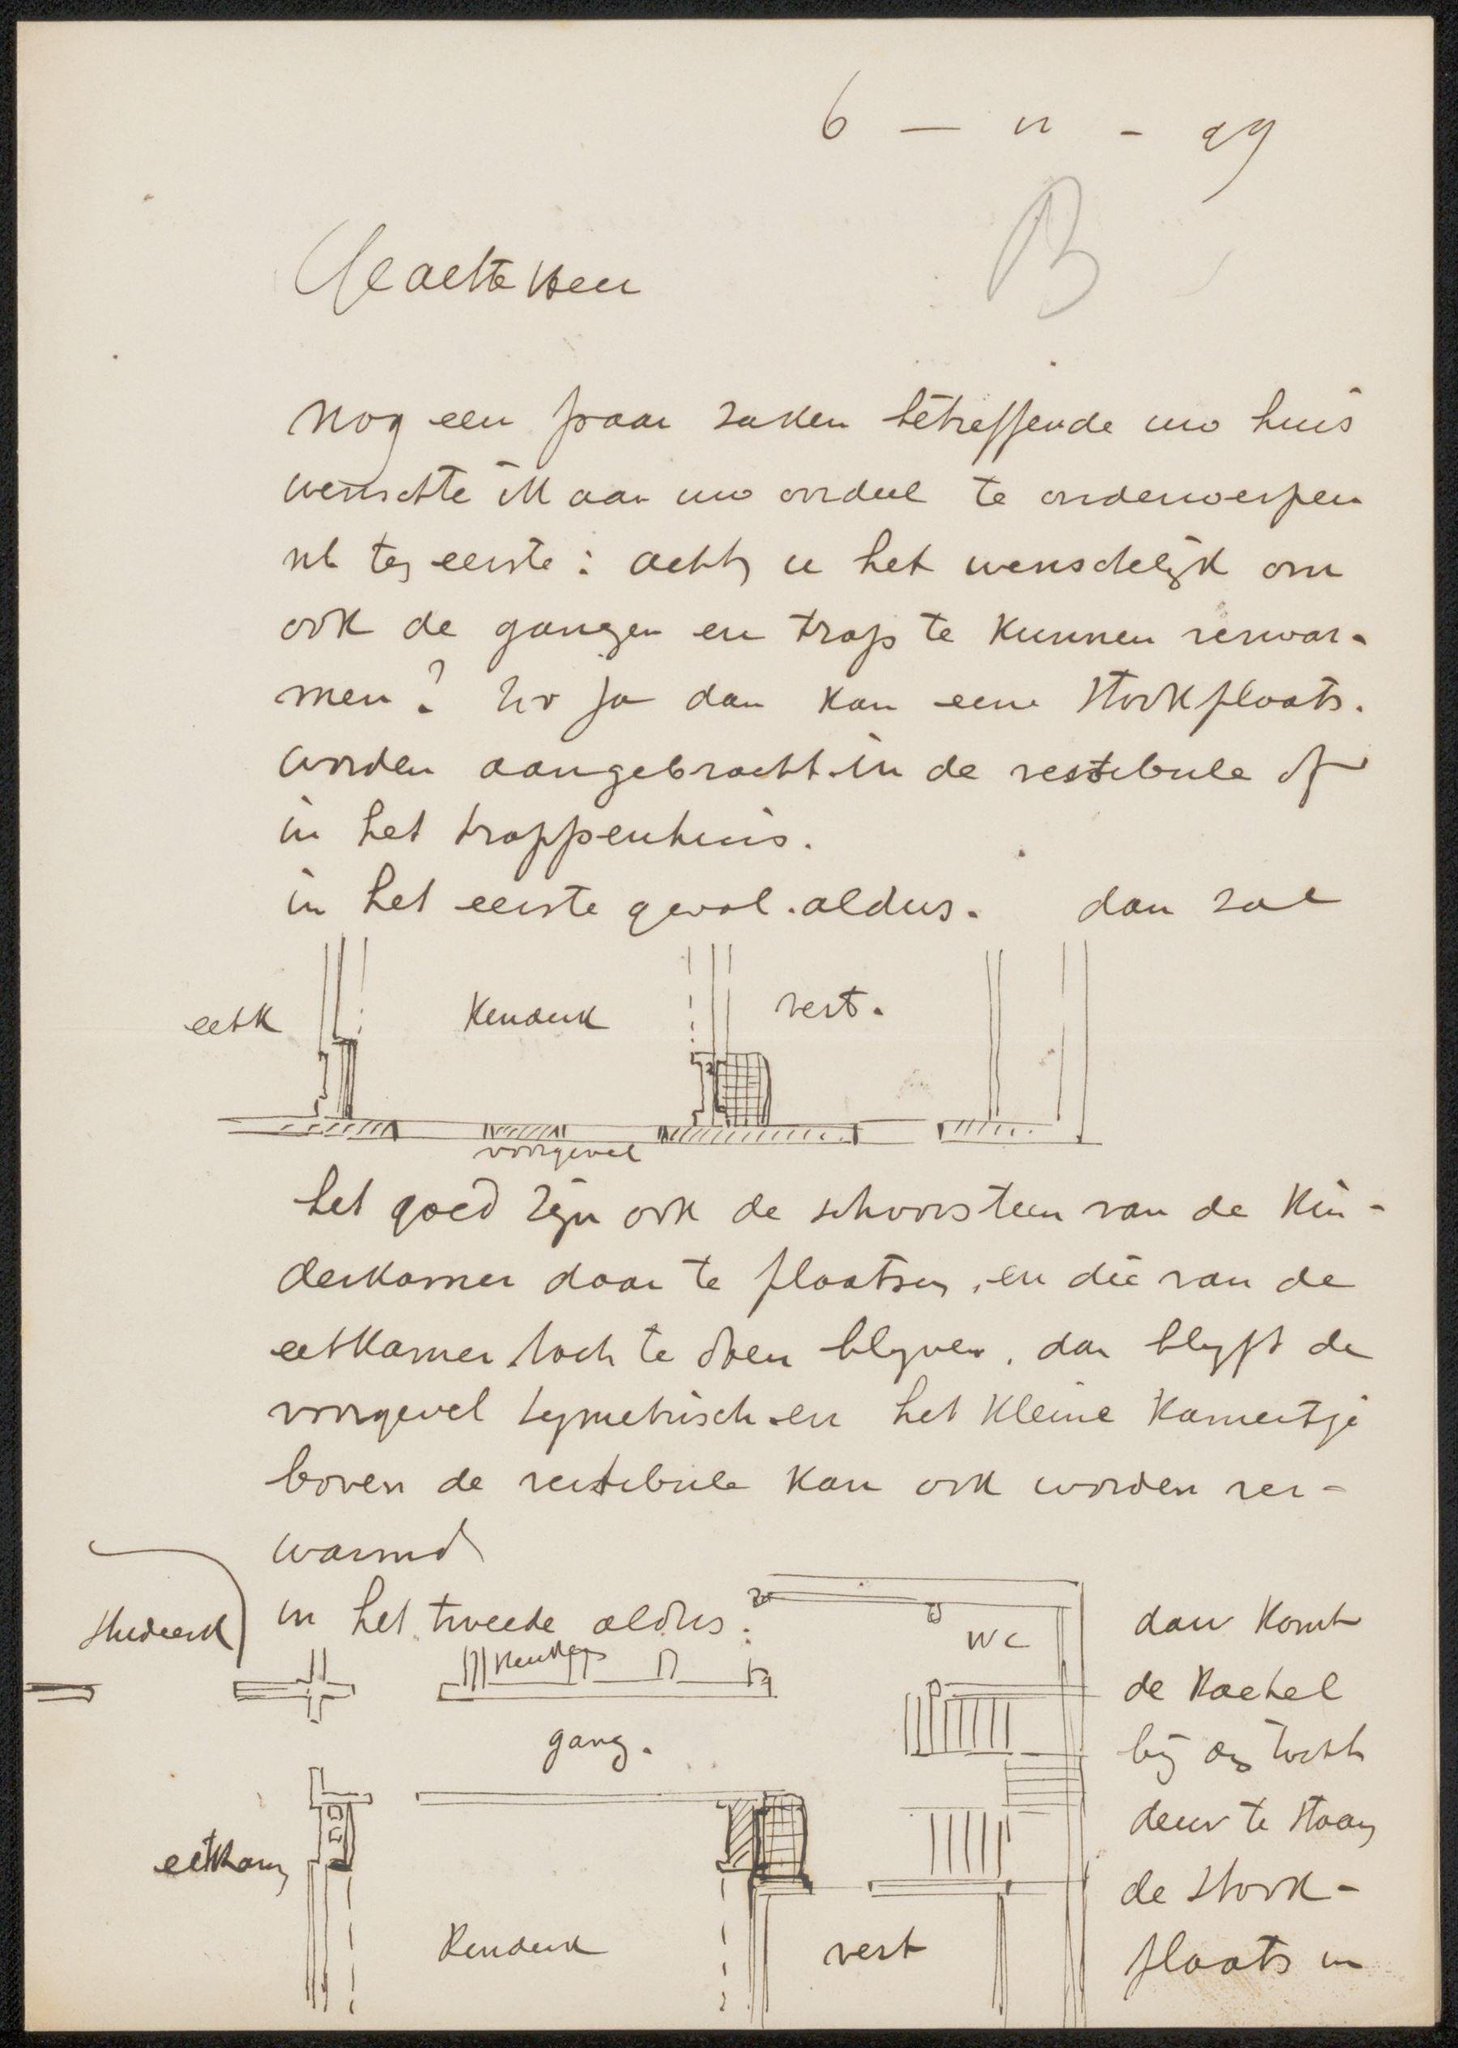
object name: letter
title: Brief aan Jan Veth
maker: karel petrus cornelis de bazel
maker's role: draughtsman, print maker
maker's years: 1869-1923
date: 1899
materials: ink, paper, pencil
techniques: pen, writing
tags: dordrecht, amsterdam, painter, print maker, draughtsman, designer, jan veth, architecture, plan ~ architecture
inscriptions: collector's mark: ‘RPK’, watermark